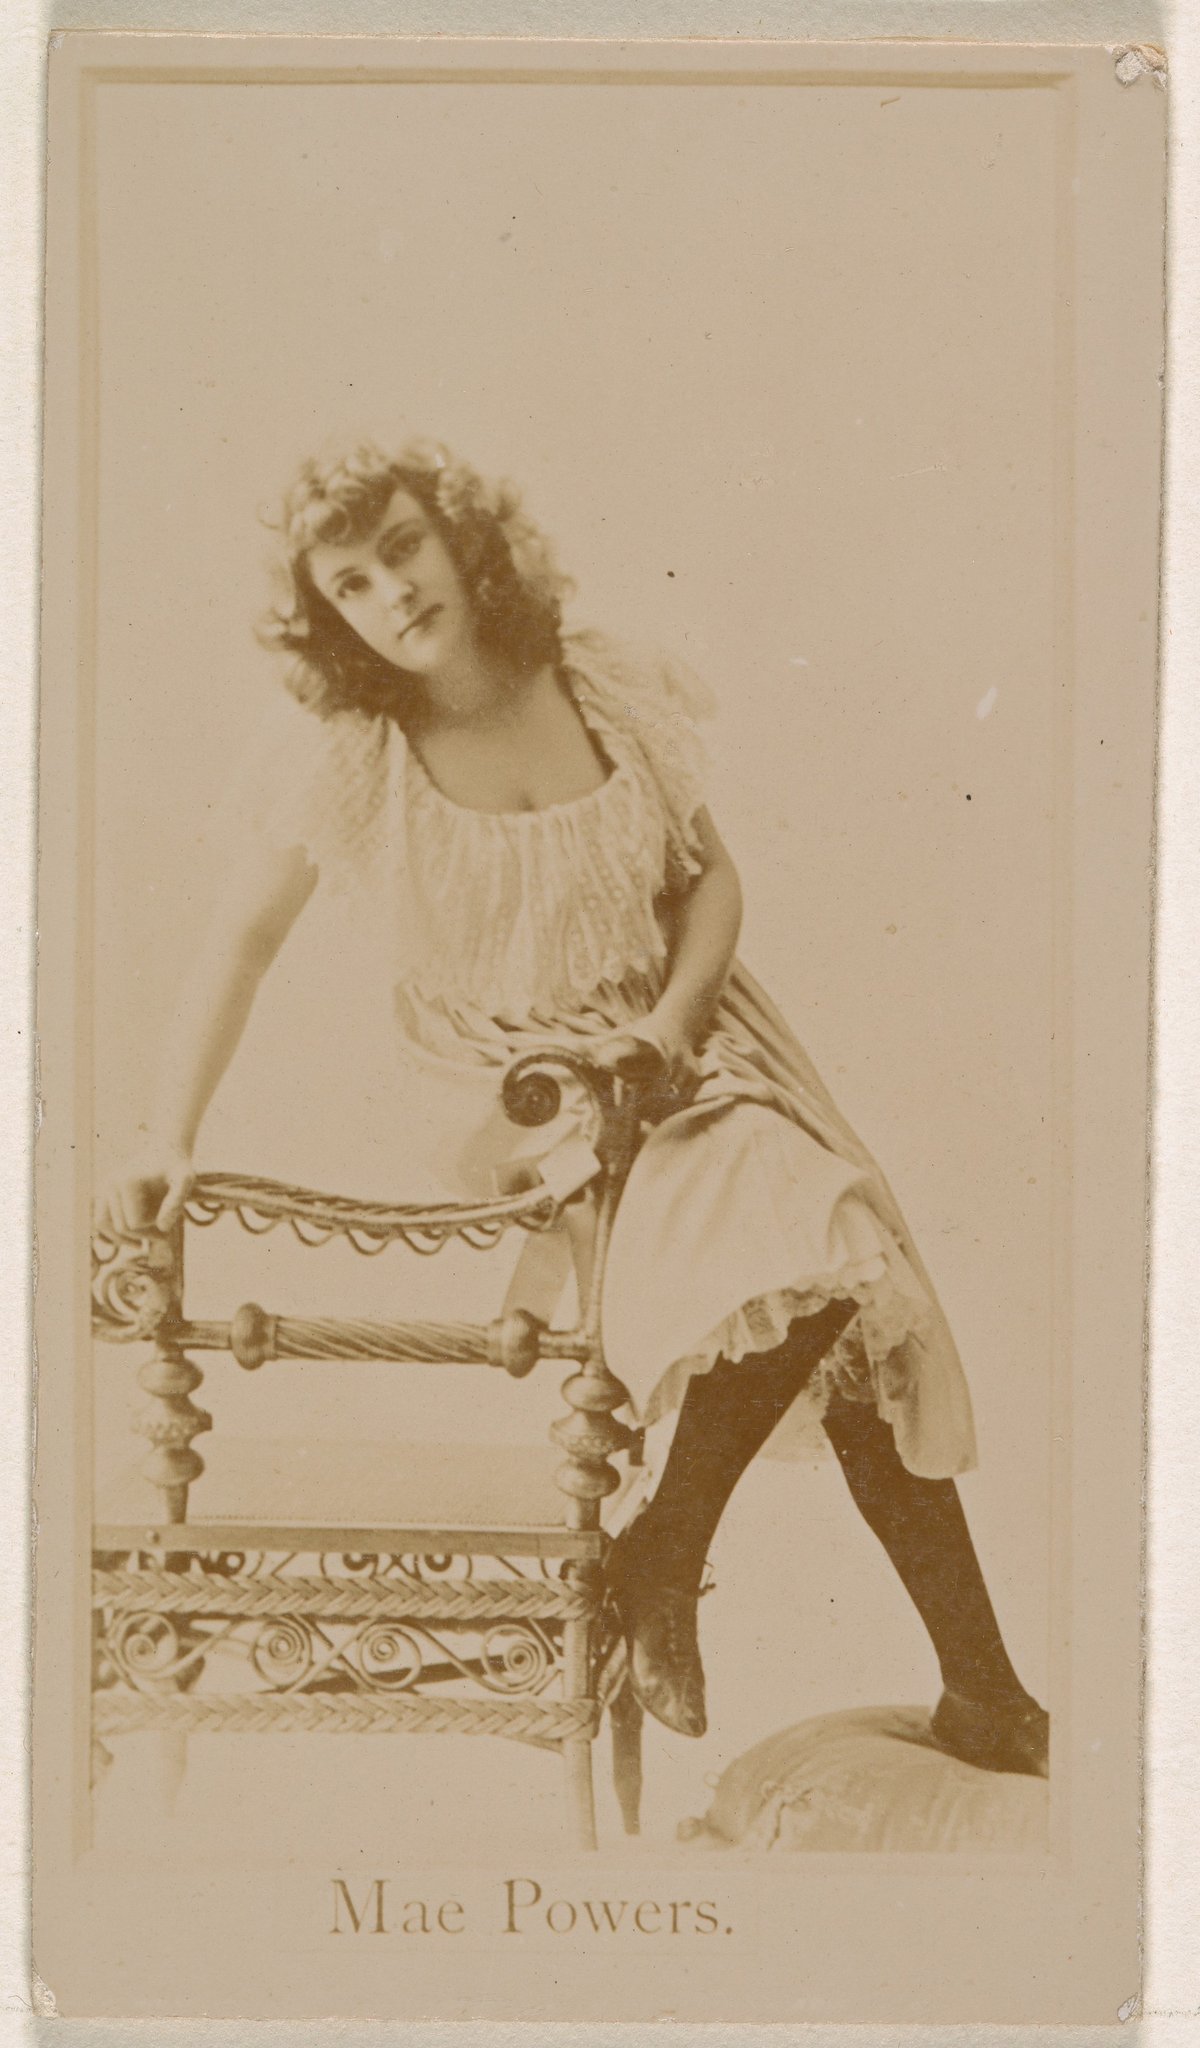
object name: photograph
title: Mae Powers, from the Actresses series (N245) issued by Kinney Brothers to promote Sweet Caporal Cigarettes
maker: kinney brothers tobacco company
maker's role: publisher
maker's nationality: american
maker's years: 1869-2011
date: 1890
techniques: albumen silver print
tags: portraits,women,actresses